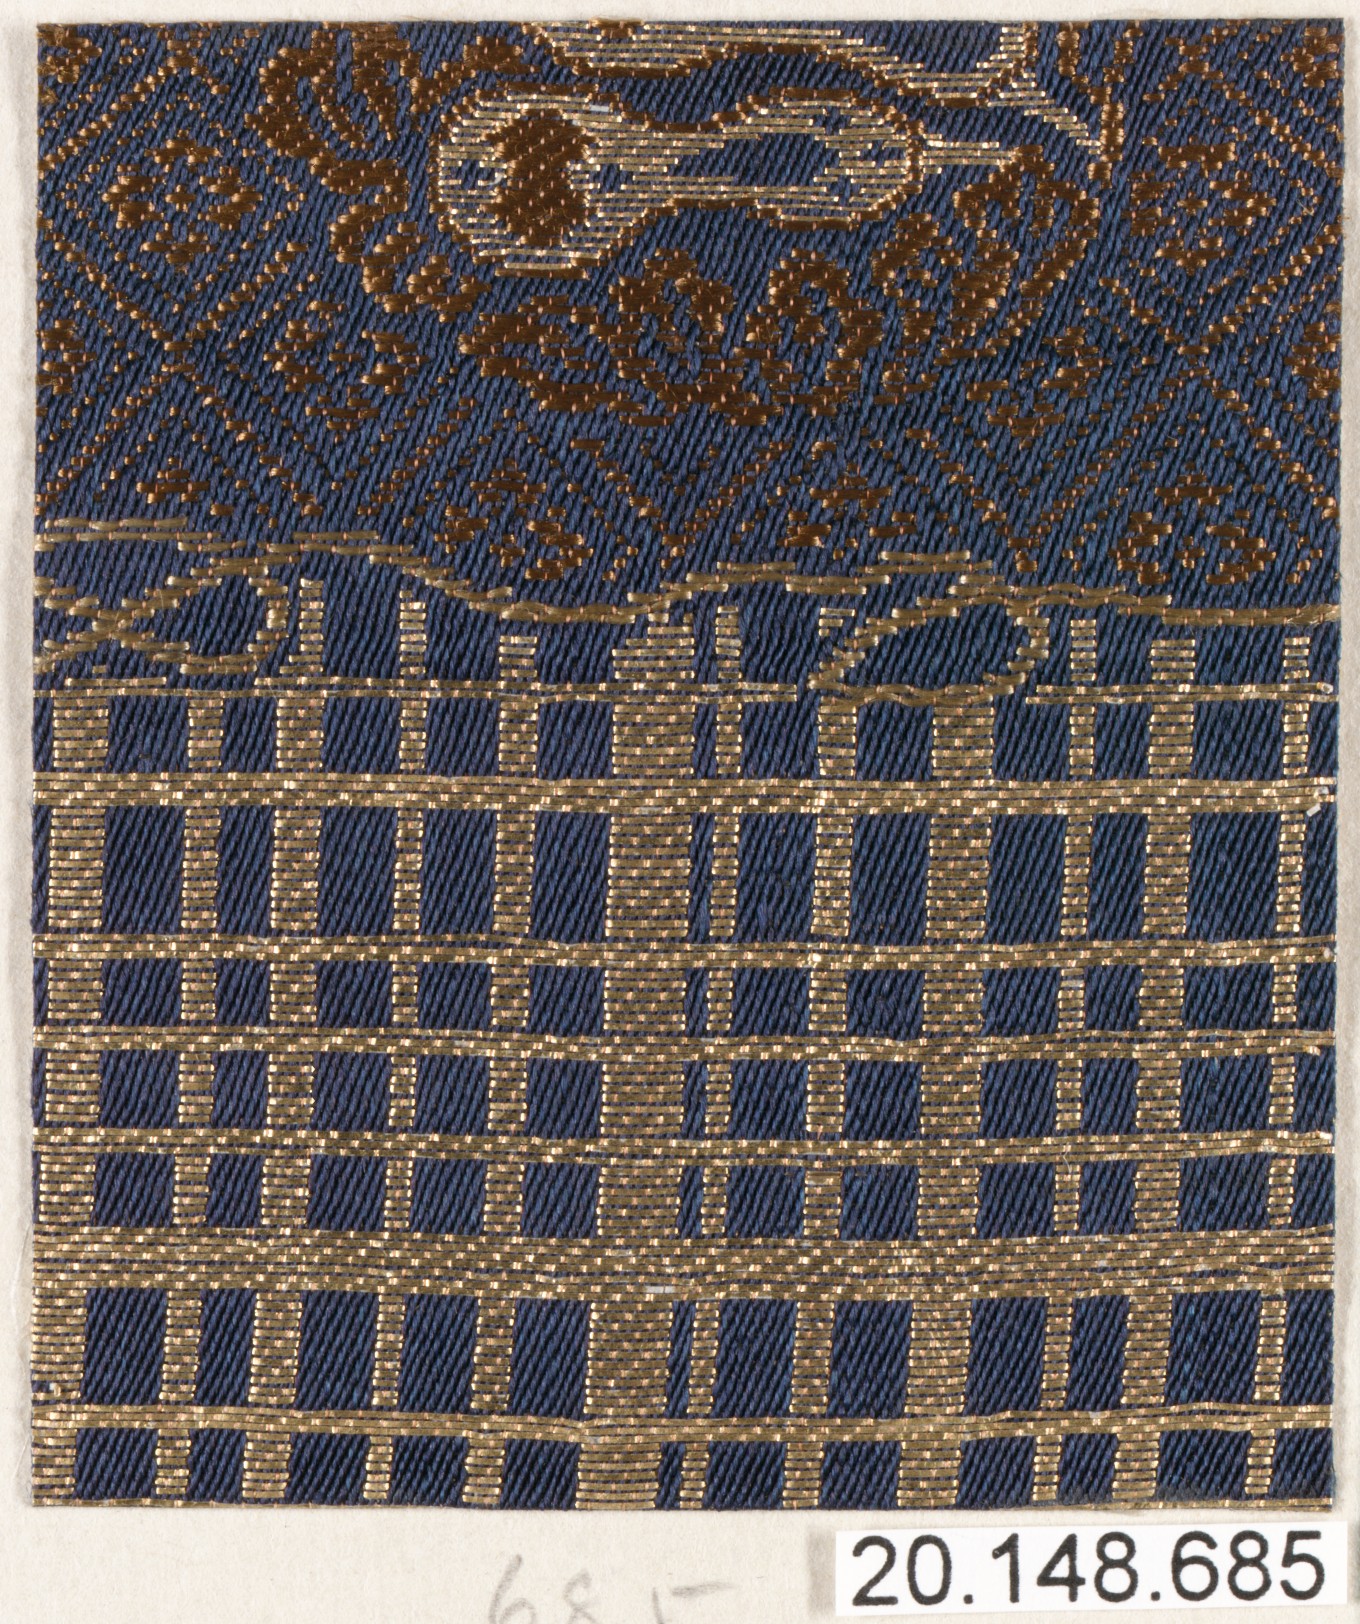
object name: piece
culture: china or japan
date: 1701-1800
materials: silk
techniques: compound weave